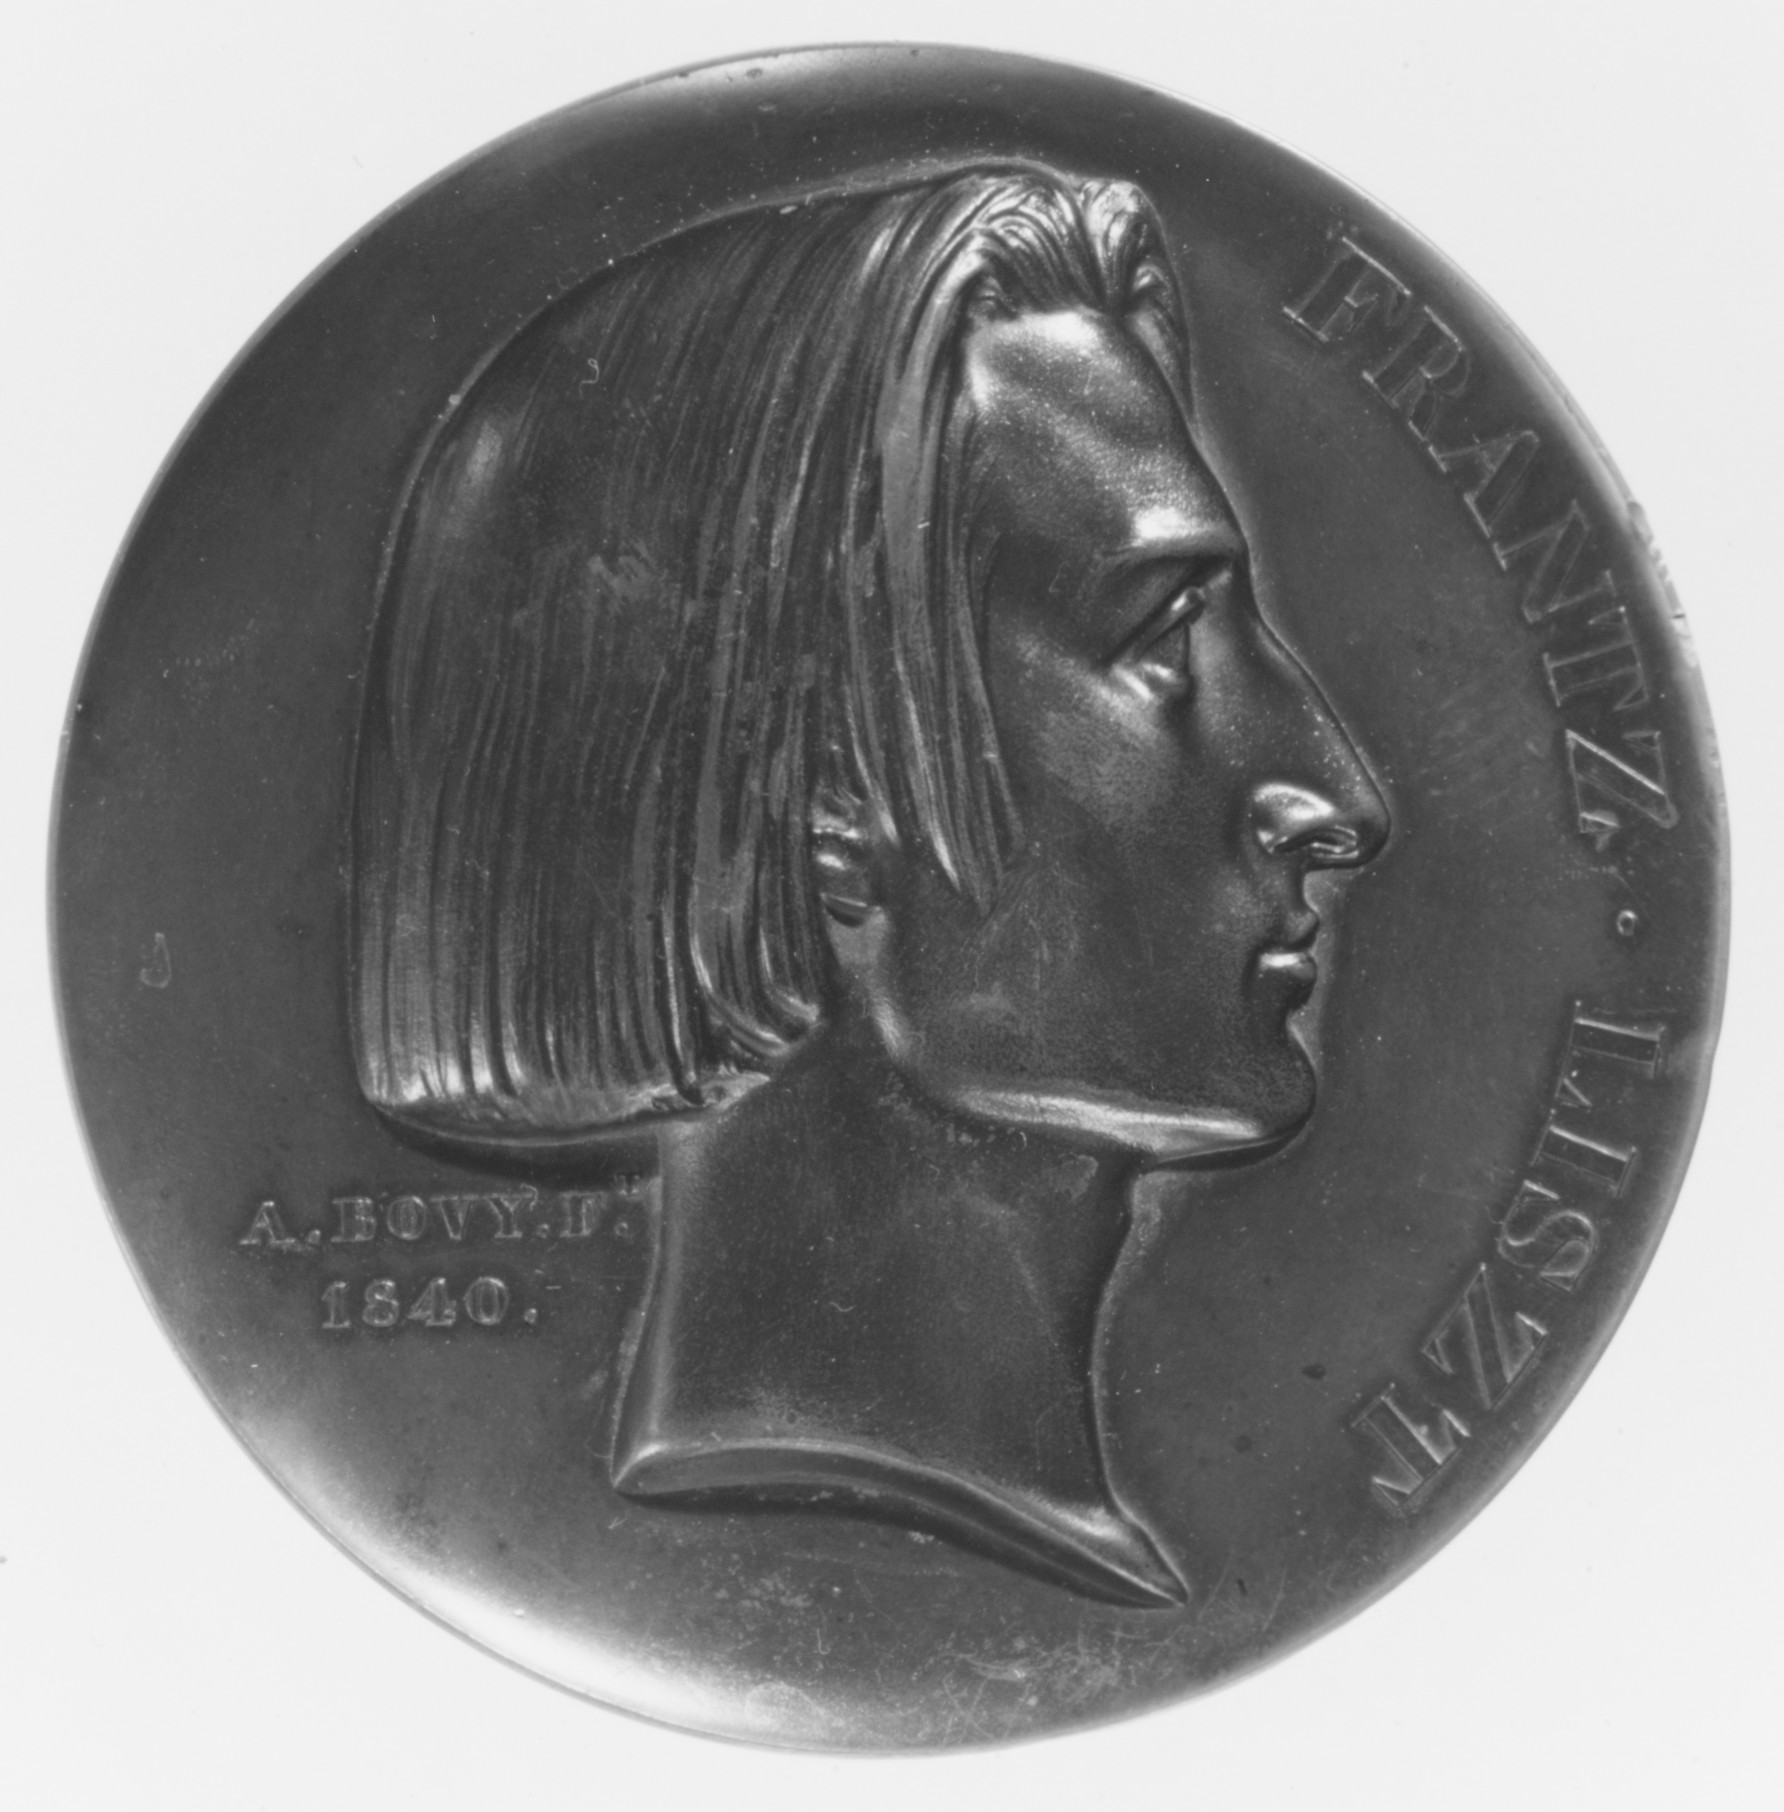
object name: medal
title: Frantz Liszt (1811–1866)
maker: jean-françois-antoine bovy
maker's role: artist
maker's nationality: french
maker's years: 1795-1877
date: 1840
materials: bronze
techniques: struck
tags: men,profiles